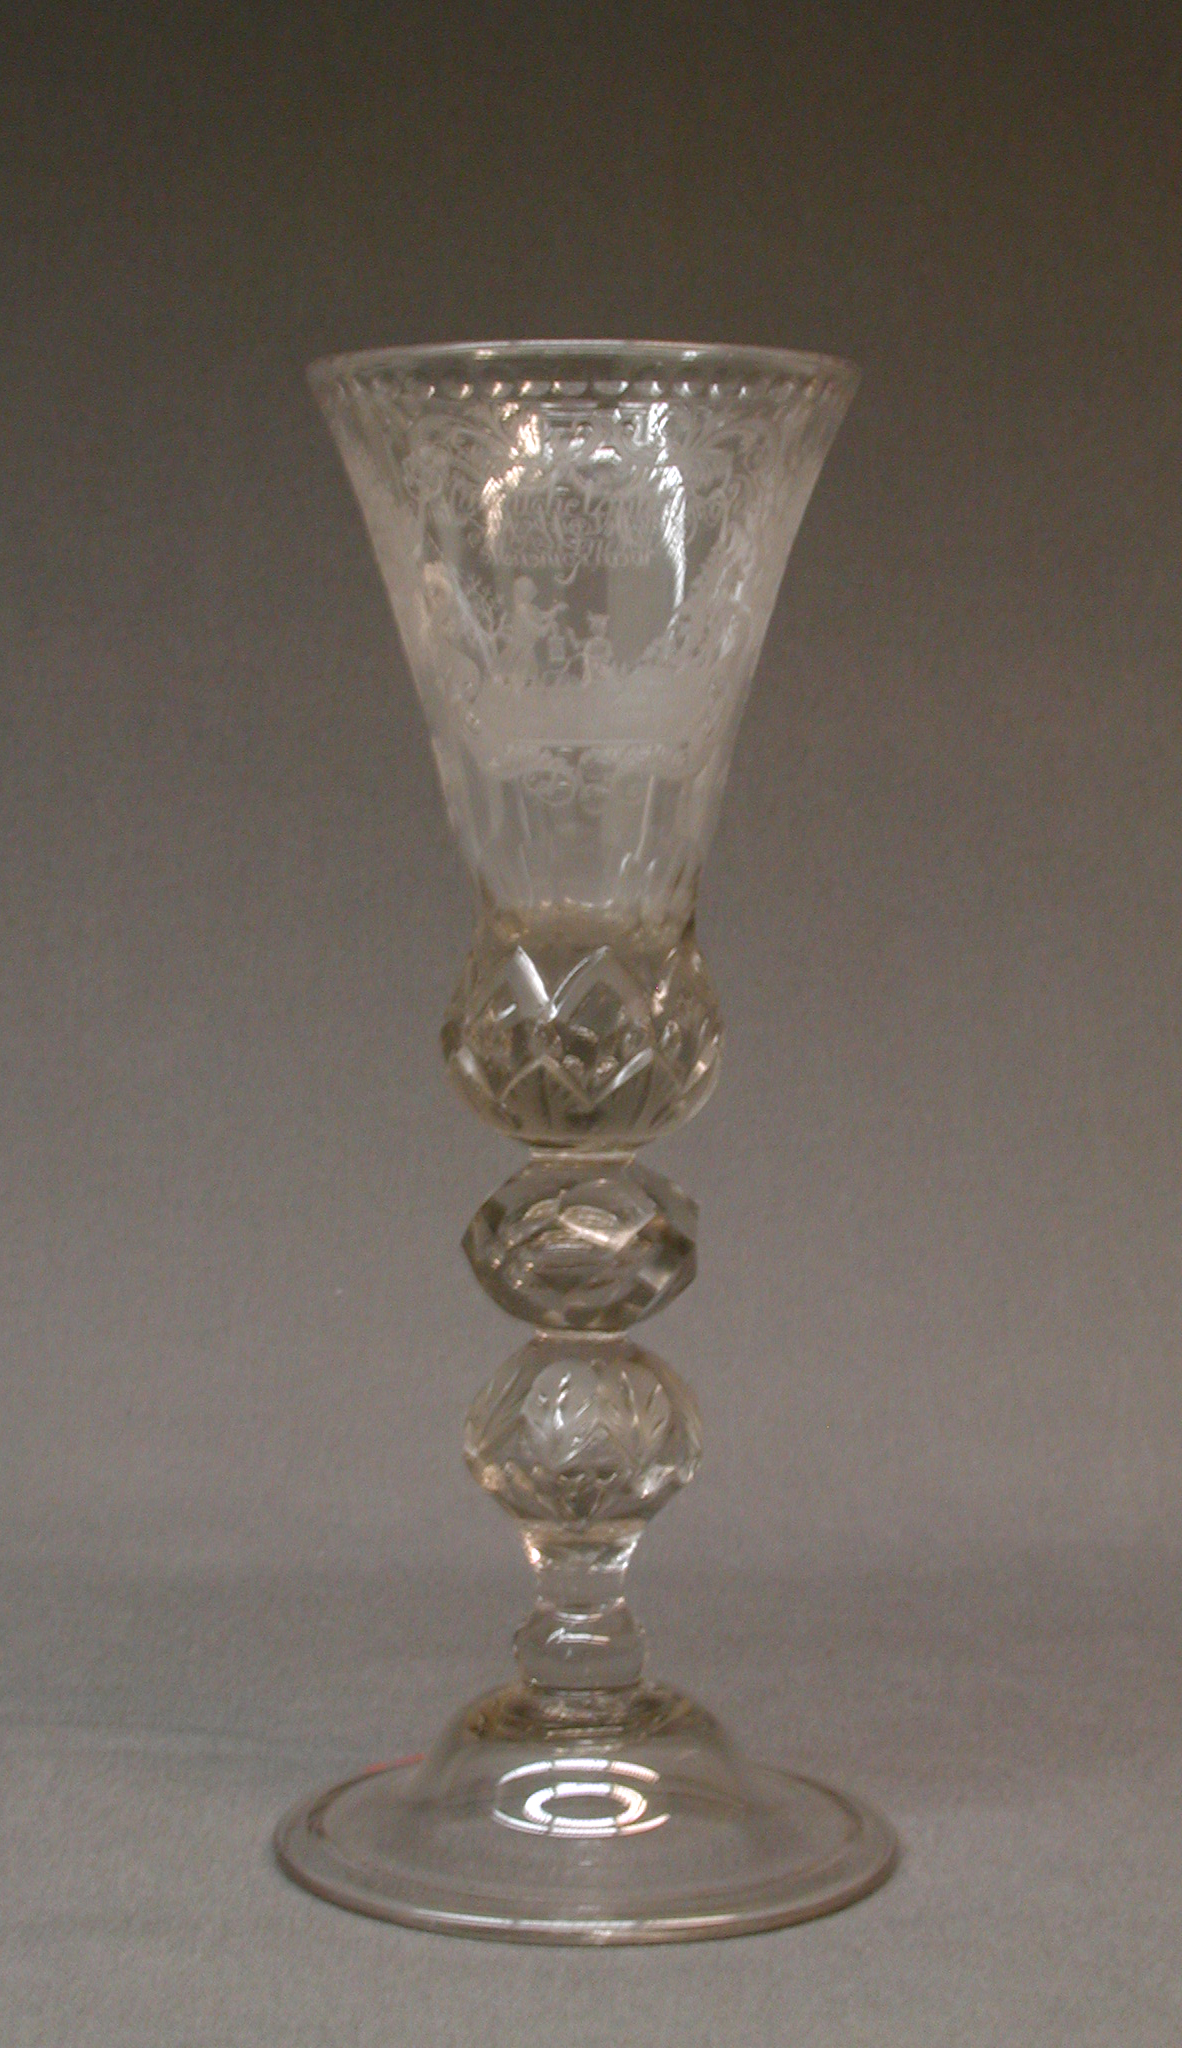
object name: standing cup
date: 1701-1750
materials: glass